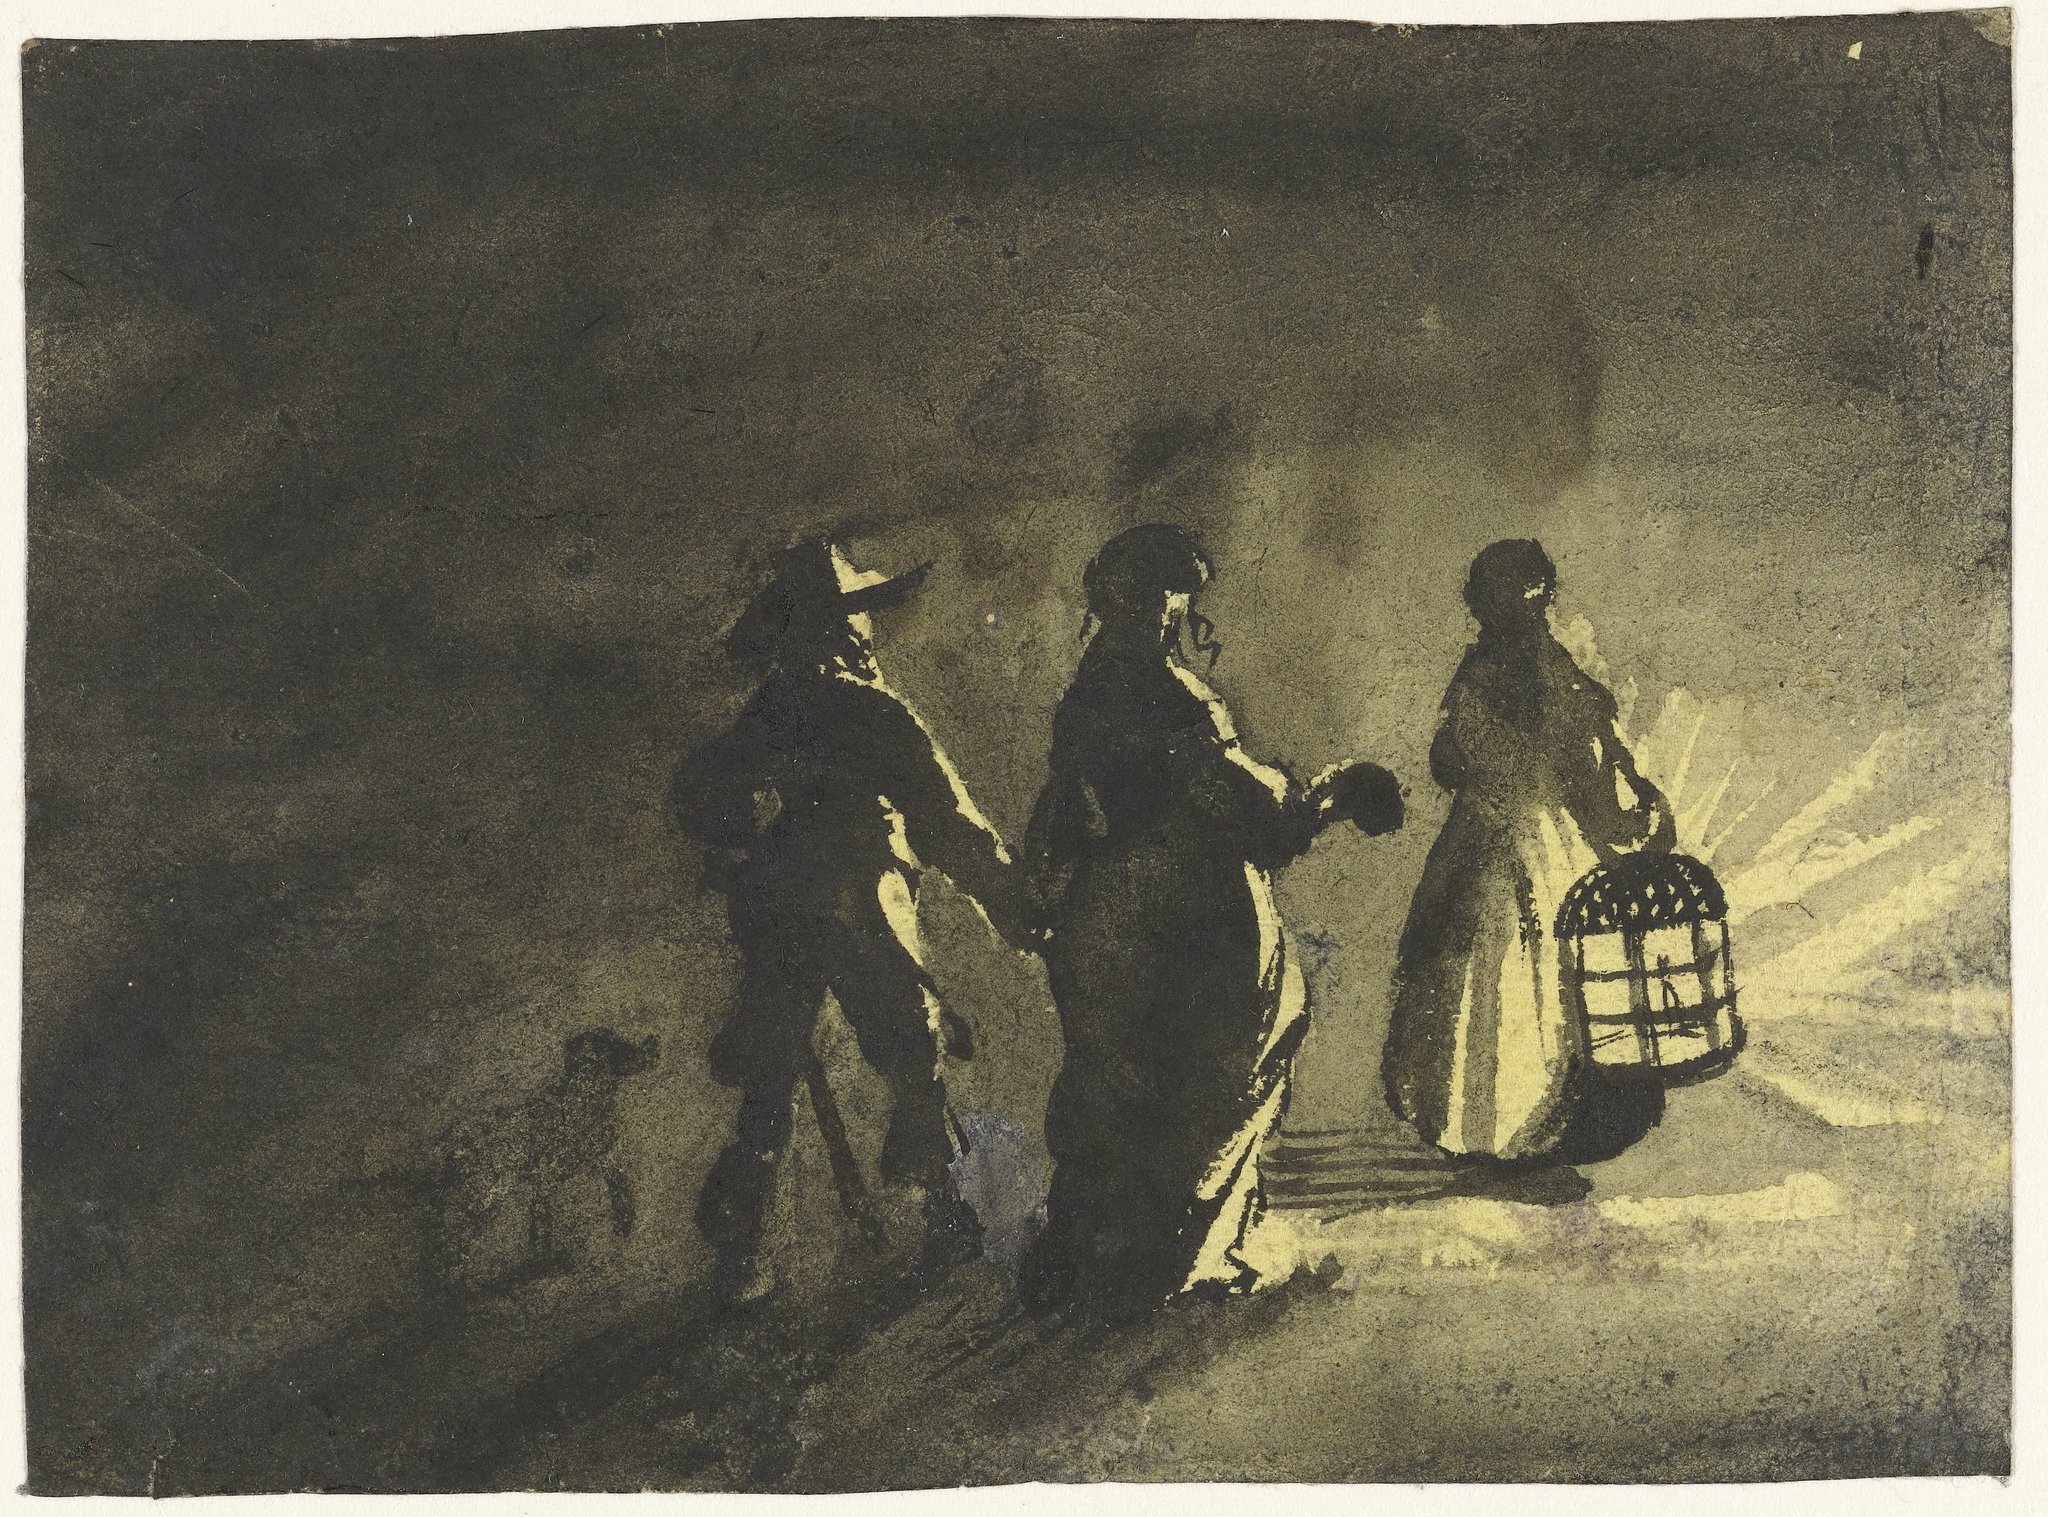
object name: drawing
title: Nocturnal Scene: Couple Walking behind a Woman with a Lantern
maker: gesina ter borch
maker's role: draughtsman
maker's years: 1633-1690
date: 1655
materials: ink, paper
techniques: brush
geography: zwolle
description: Gesina ter Borch had a penchant for night scenes. In this enchanting little piece, two lovers walk hand in hand in the dark, accompanied by a dog. Their path is lit by a woman with a lantern. Ter Borch first prepared the sheet with a layer of yellow watercolour, which accentuates the warm glow of the candlelight.